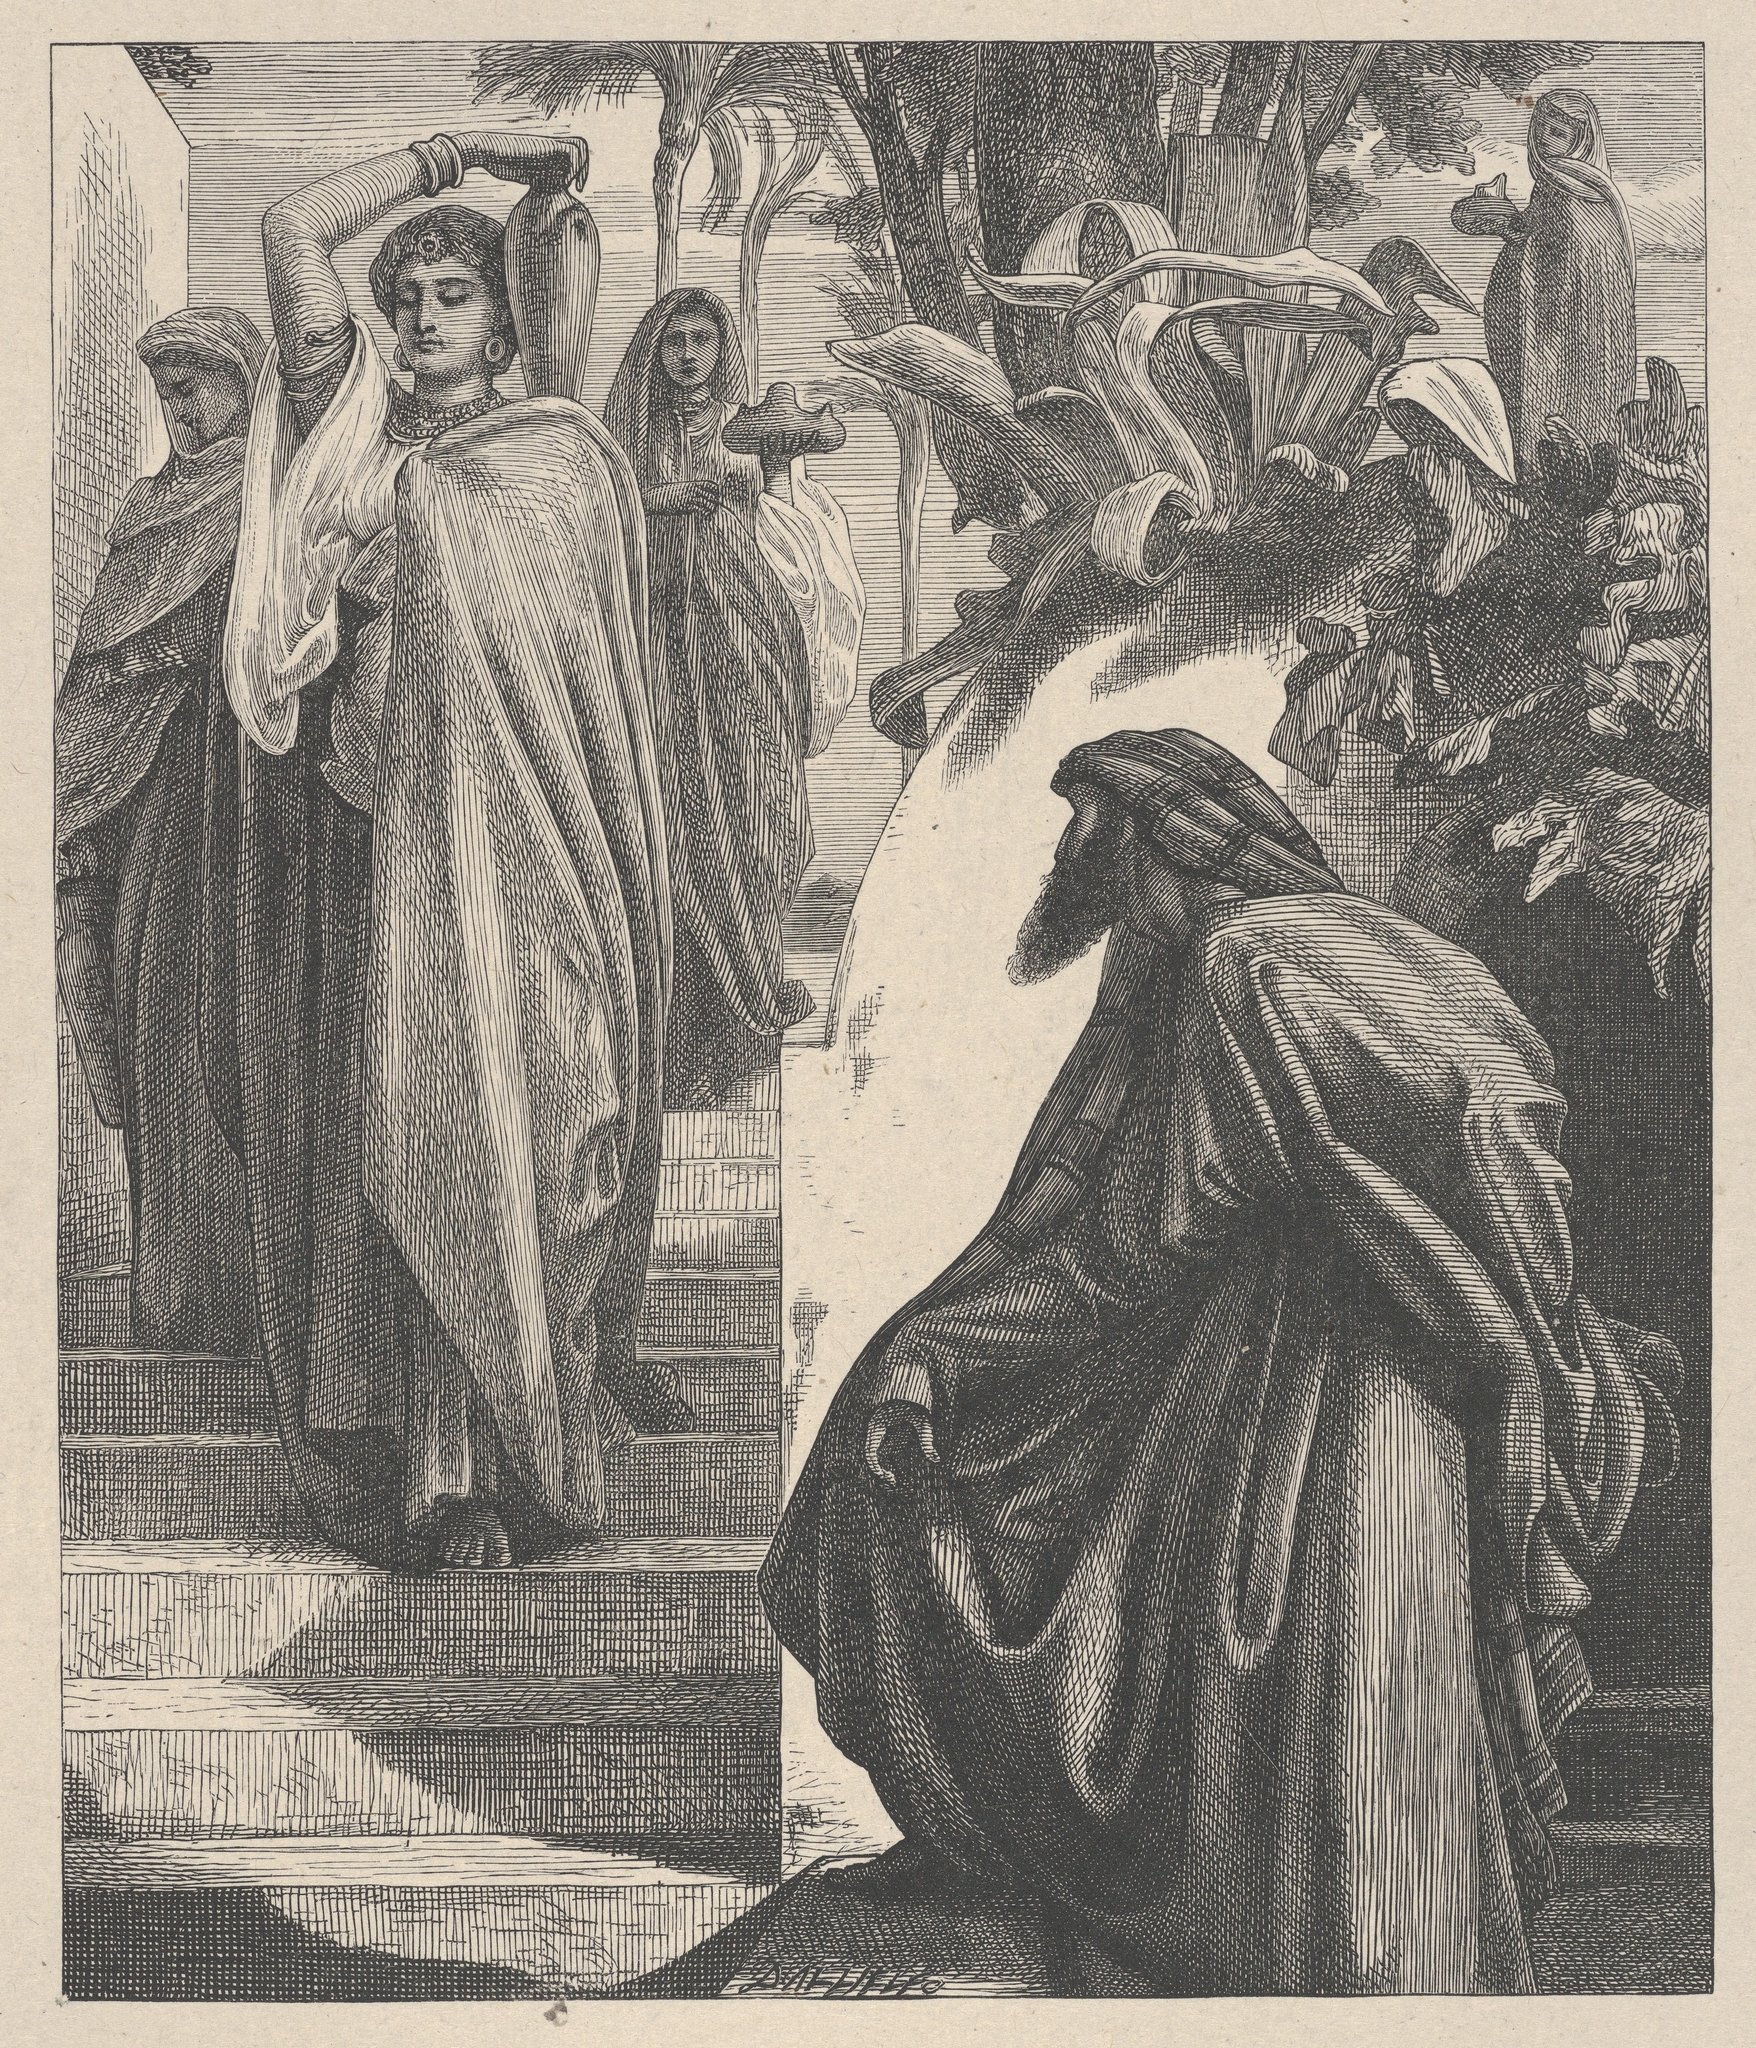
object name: print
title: Eliezer and Rebekah, from "Dalziels' Bible Gallery"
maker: frederic, lord leighton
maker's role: artist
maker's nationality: british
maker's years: 1830-1896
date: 1865-1881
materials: paper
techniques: engraving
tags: men,women